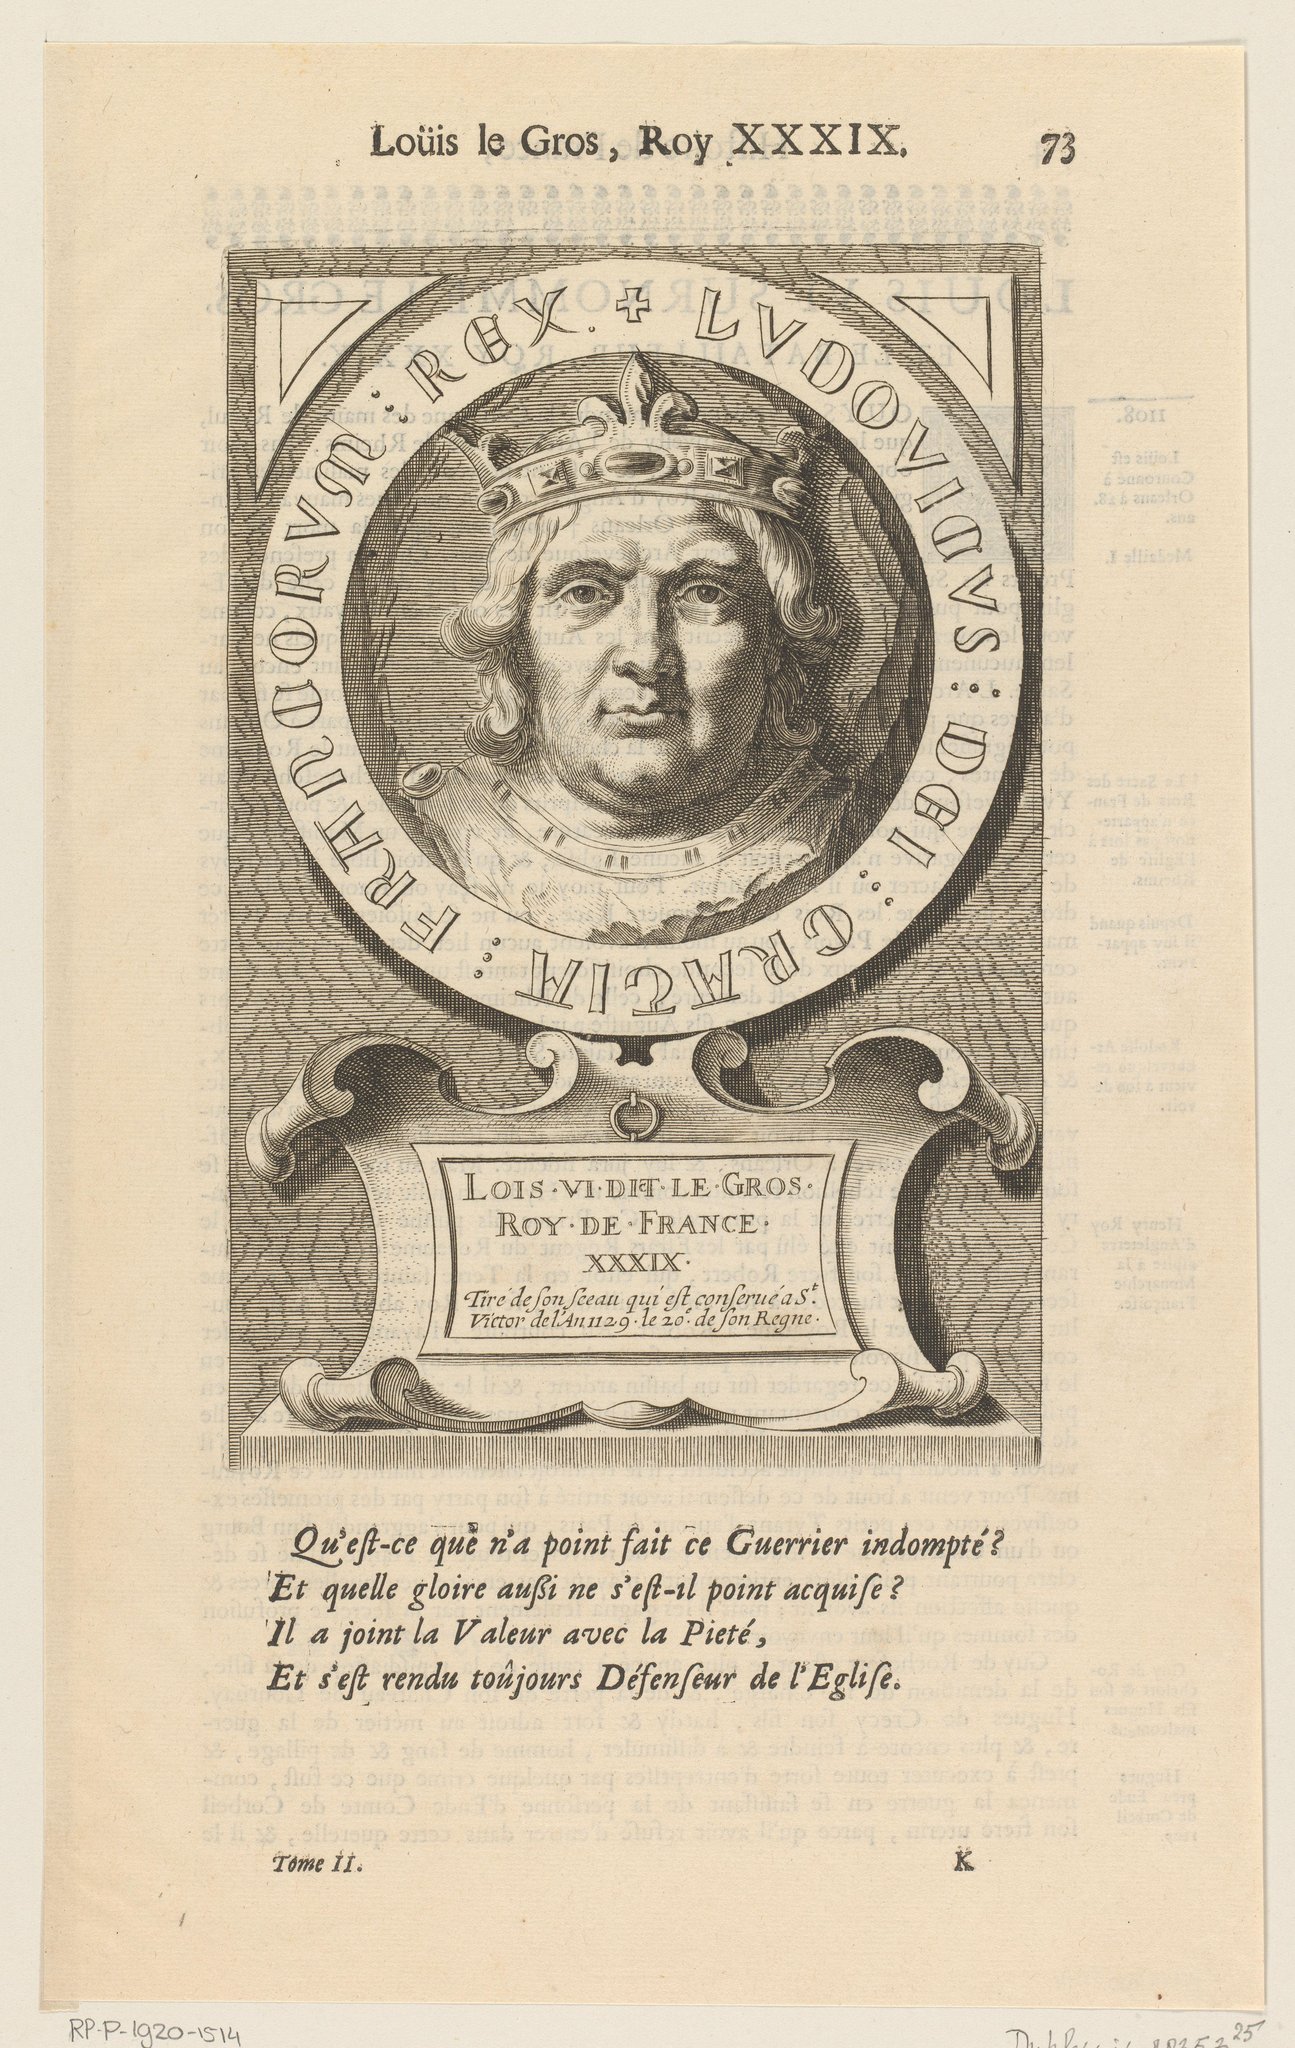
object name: print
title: Portret van Lodewijk VI, koning van Frankrijk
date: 1635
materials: paper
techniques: engraving, letterpress printing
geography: paris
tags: historical persons, ruler, sovereign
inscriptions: collector's mark: Lugt 2228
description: Prent uit: Eudes de Mézeray, François. Histoire de France, depuis Faramond jusqu’au regne de Louis le Juste (...). 3 dln. Parijs: Denis Thierry, Jean Guignard en Claude Barbin, 1635, dl. 2. Prent waarschijnlijk voor het eerst verschenen in: Bie, Jacques de. Les vrais portraits des rois de France (...). Parijs: Jacques de Bie en Pierre Rocolet, 1634. Prent ook gebruikt in latere publicaties.